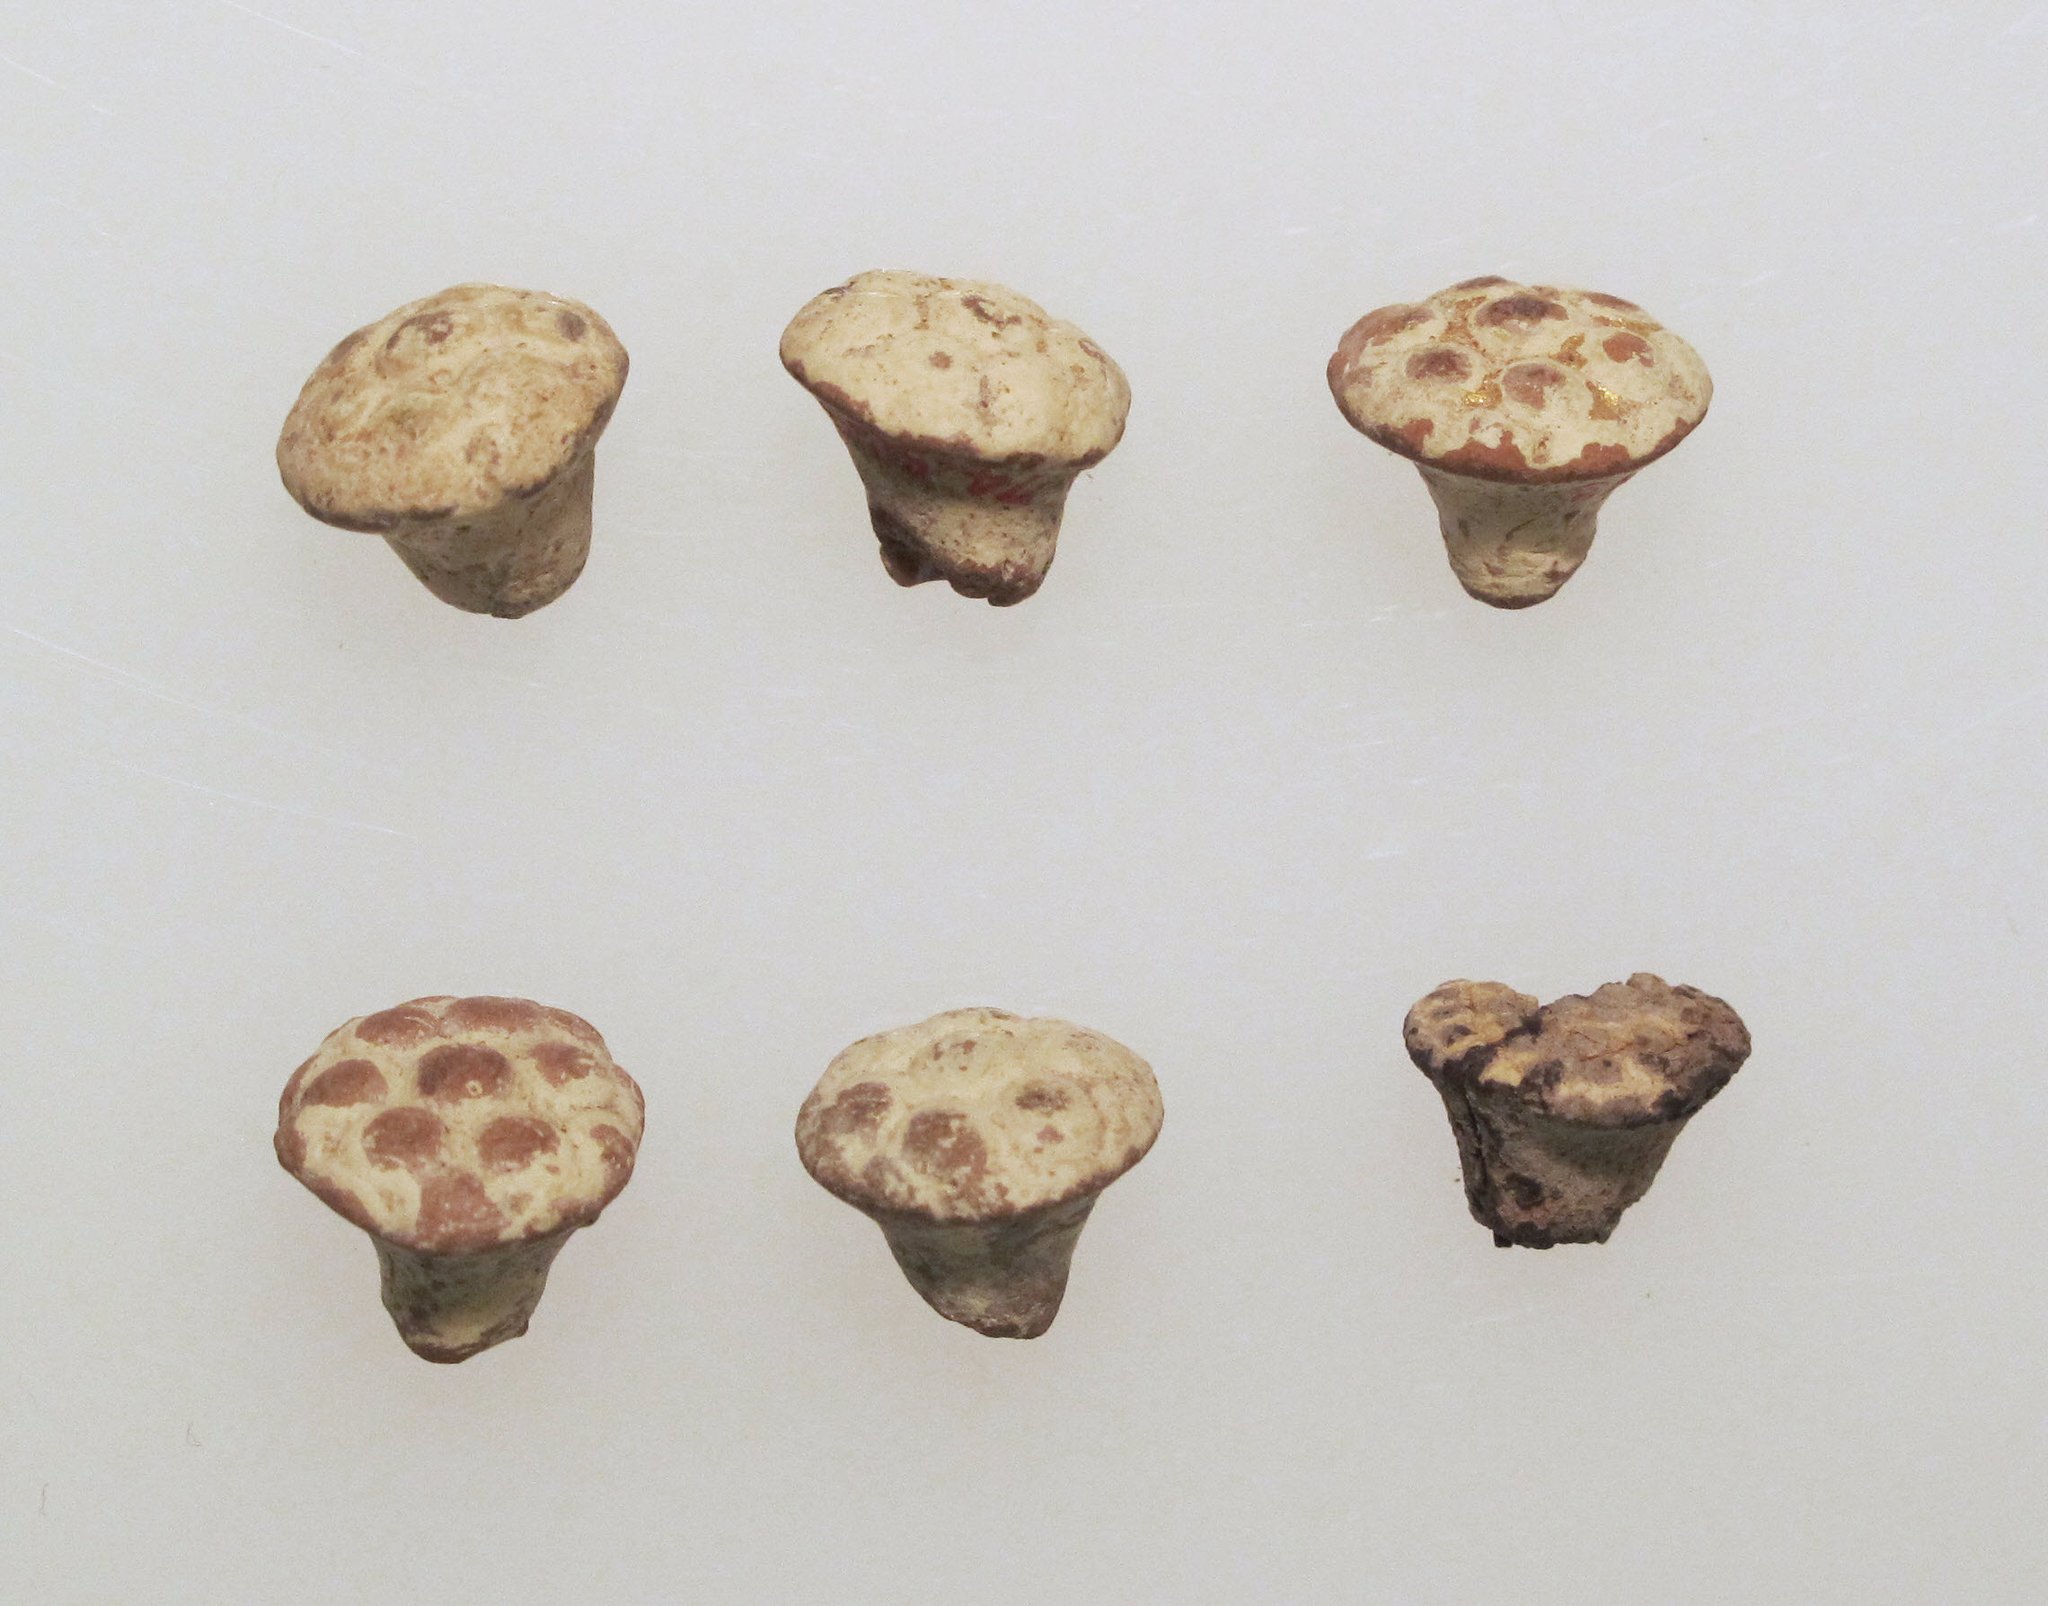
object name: pendant of gilded clay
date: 7000 BCE-330 CE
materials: clay, gold